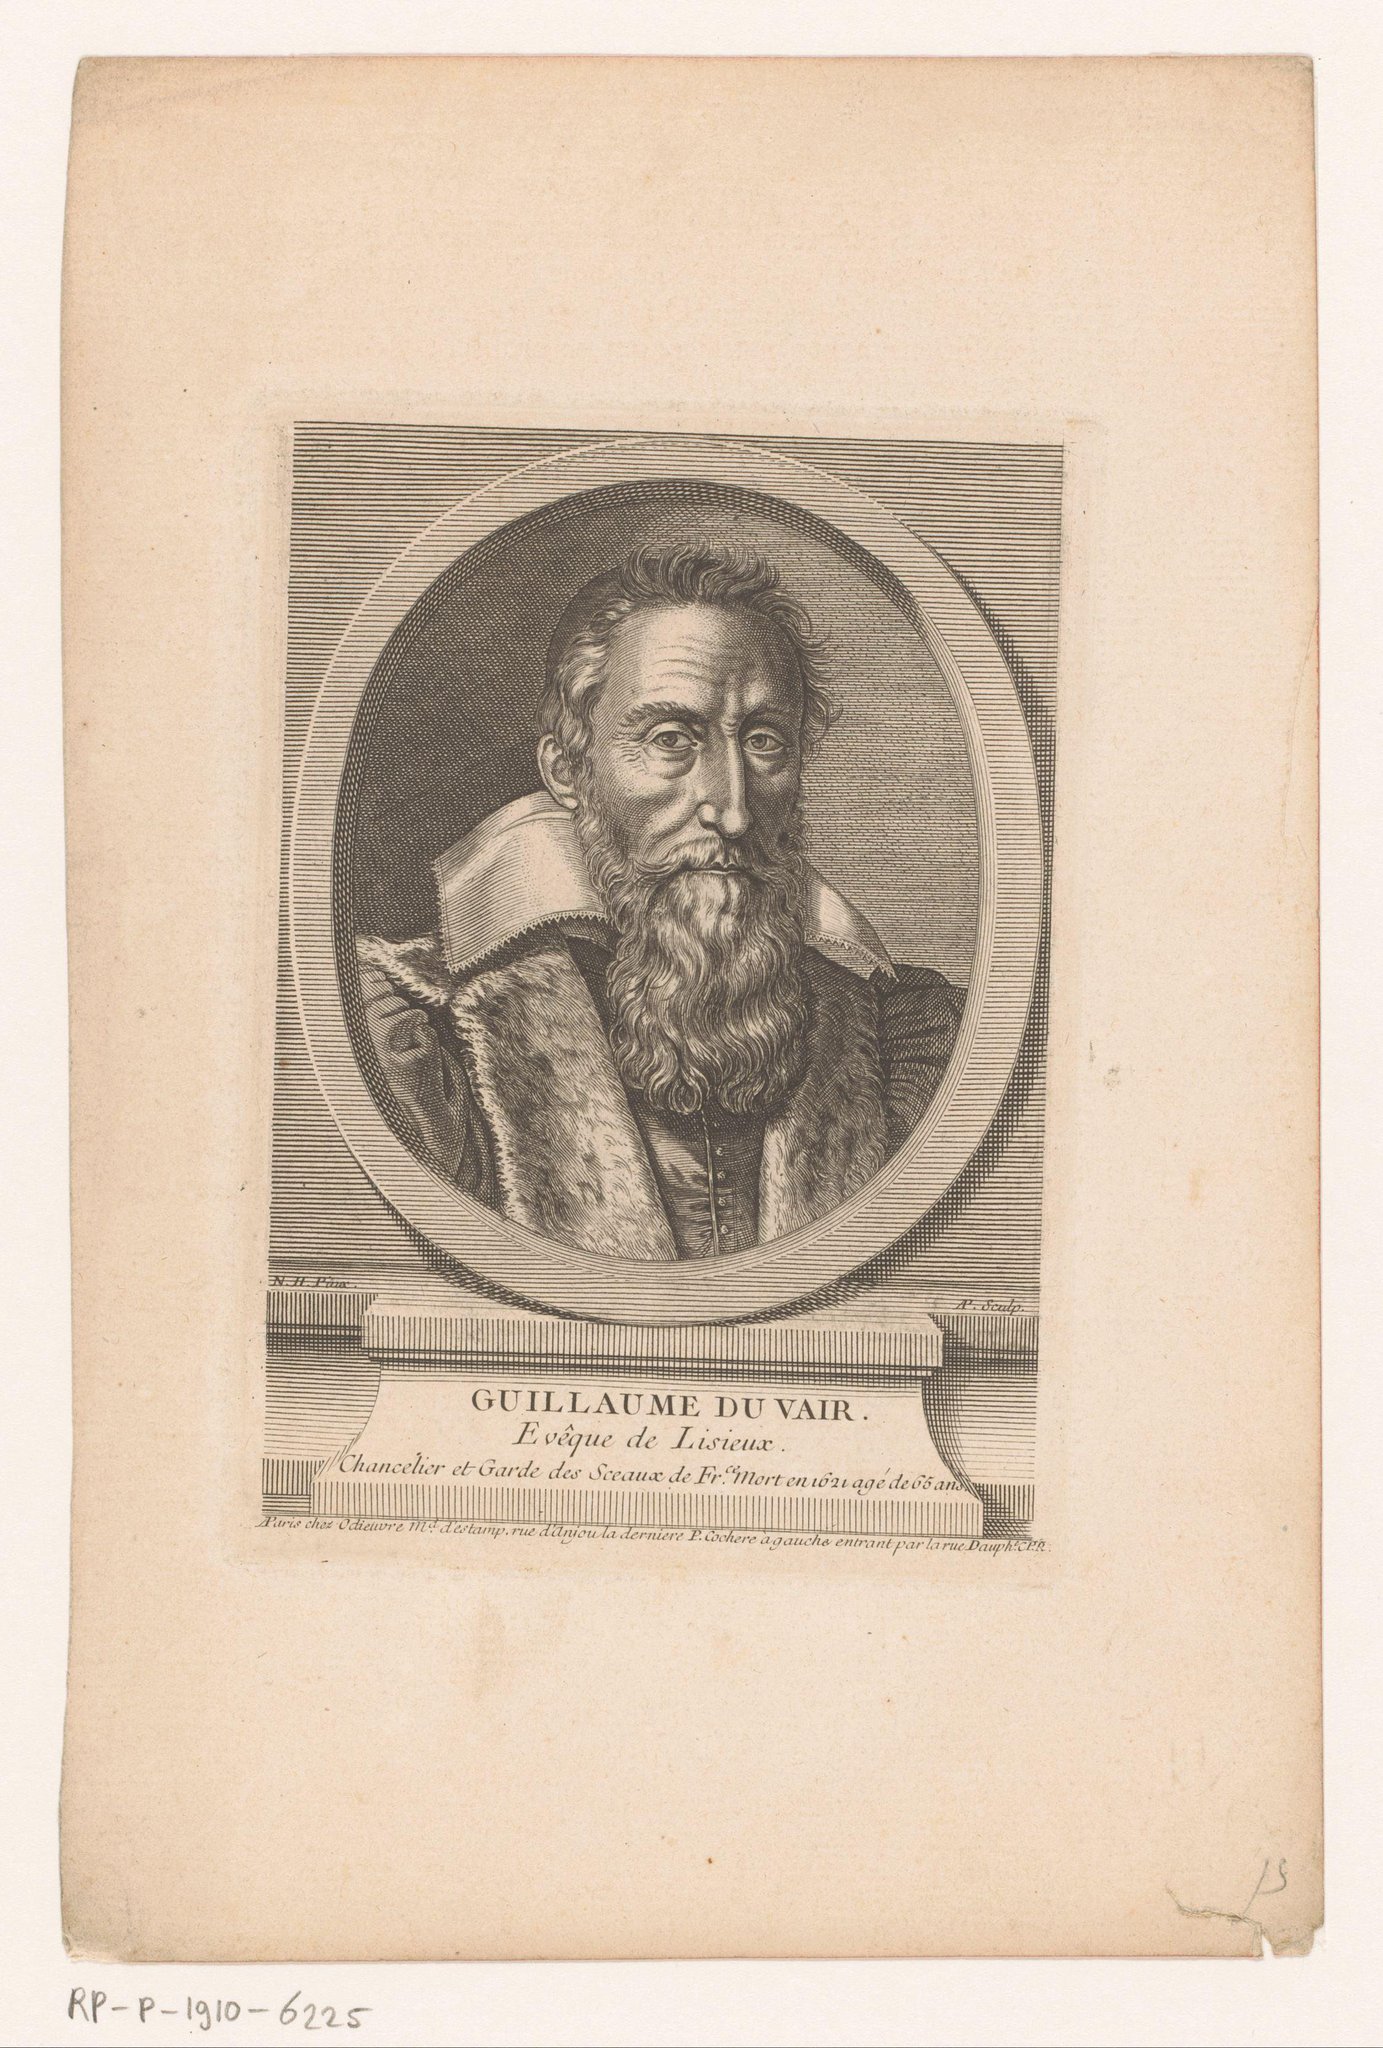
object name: print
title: Guillaume du Vair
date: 1755-1765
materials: paper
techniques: engraving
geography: paris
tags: france, historical persons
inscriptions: collector's mark: Lugt 2228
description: Mogelijk prent uit: Dreux du Radier, Jean-François. L'Europe illustré, contenant l'histoire abregée des souverains, des princes, des prélats, des ministres, (...) en Europe: dans le XVe. siècle compris, jusqu'à présent. Parijs: Michel Odieuvre en André-François Le Breton, 1755-1765.